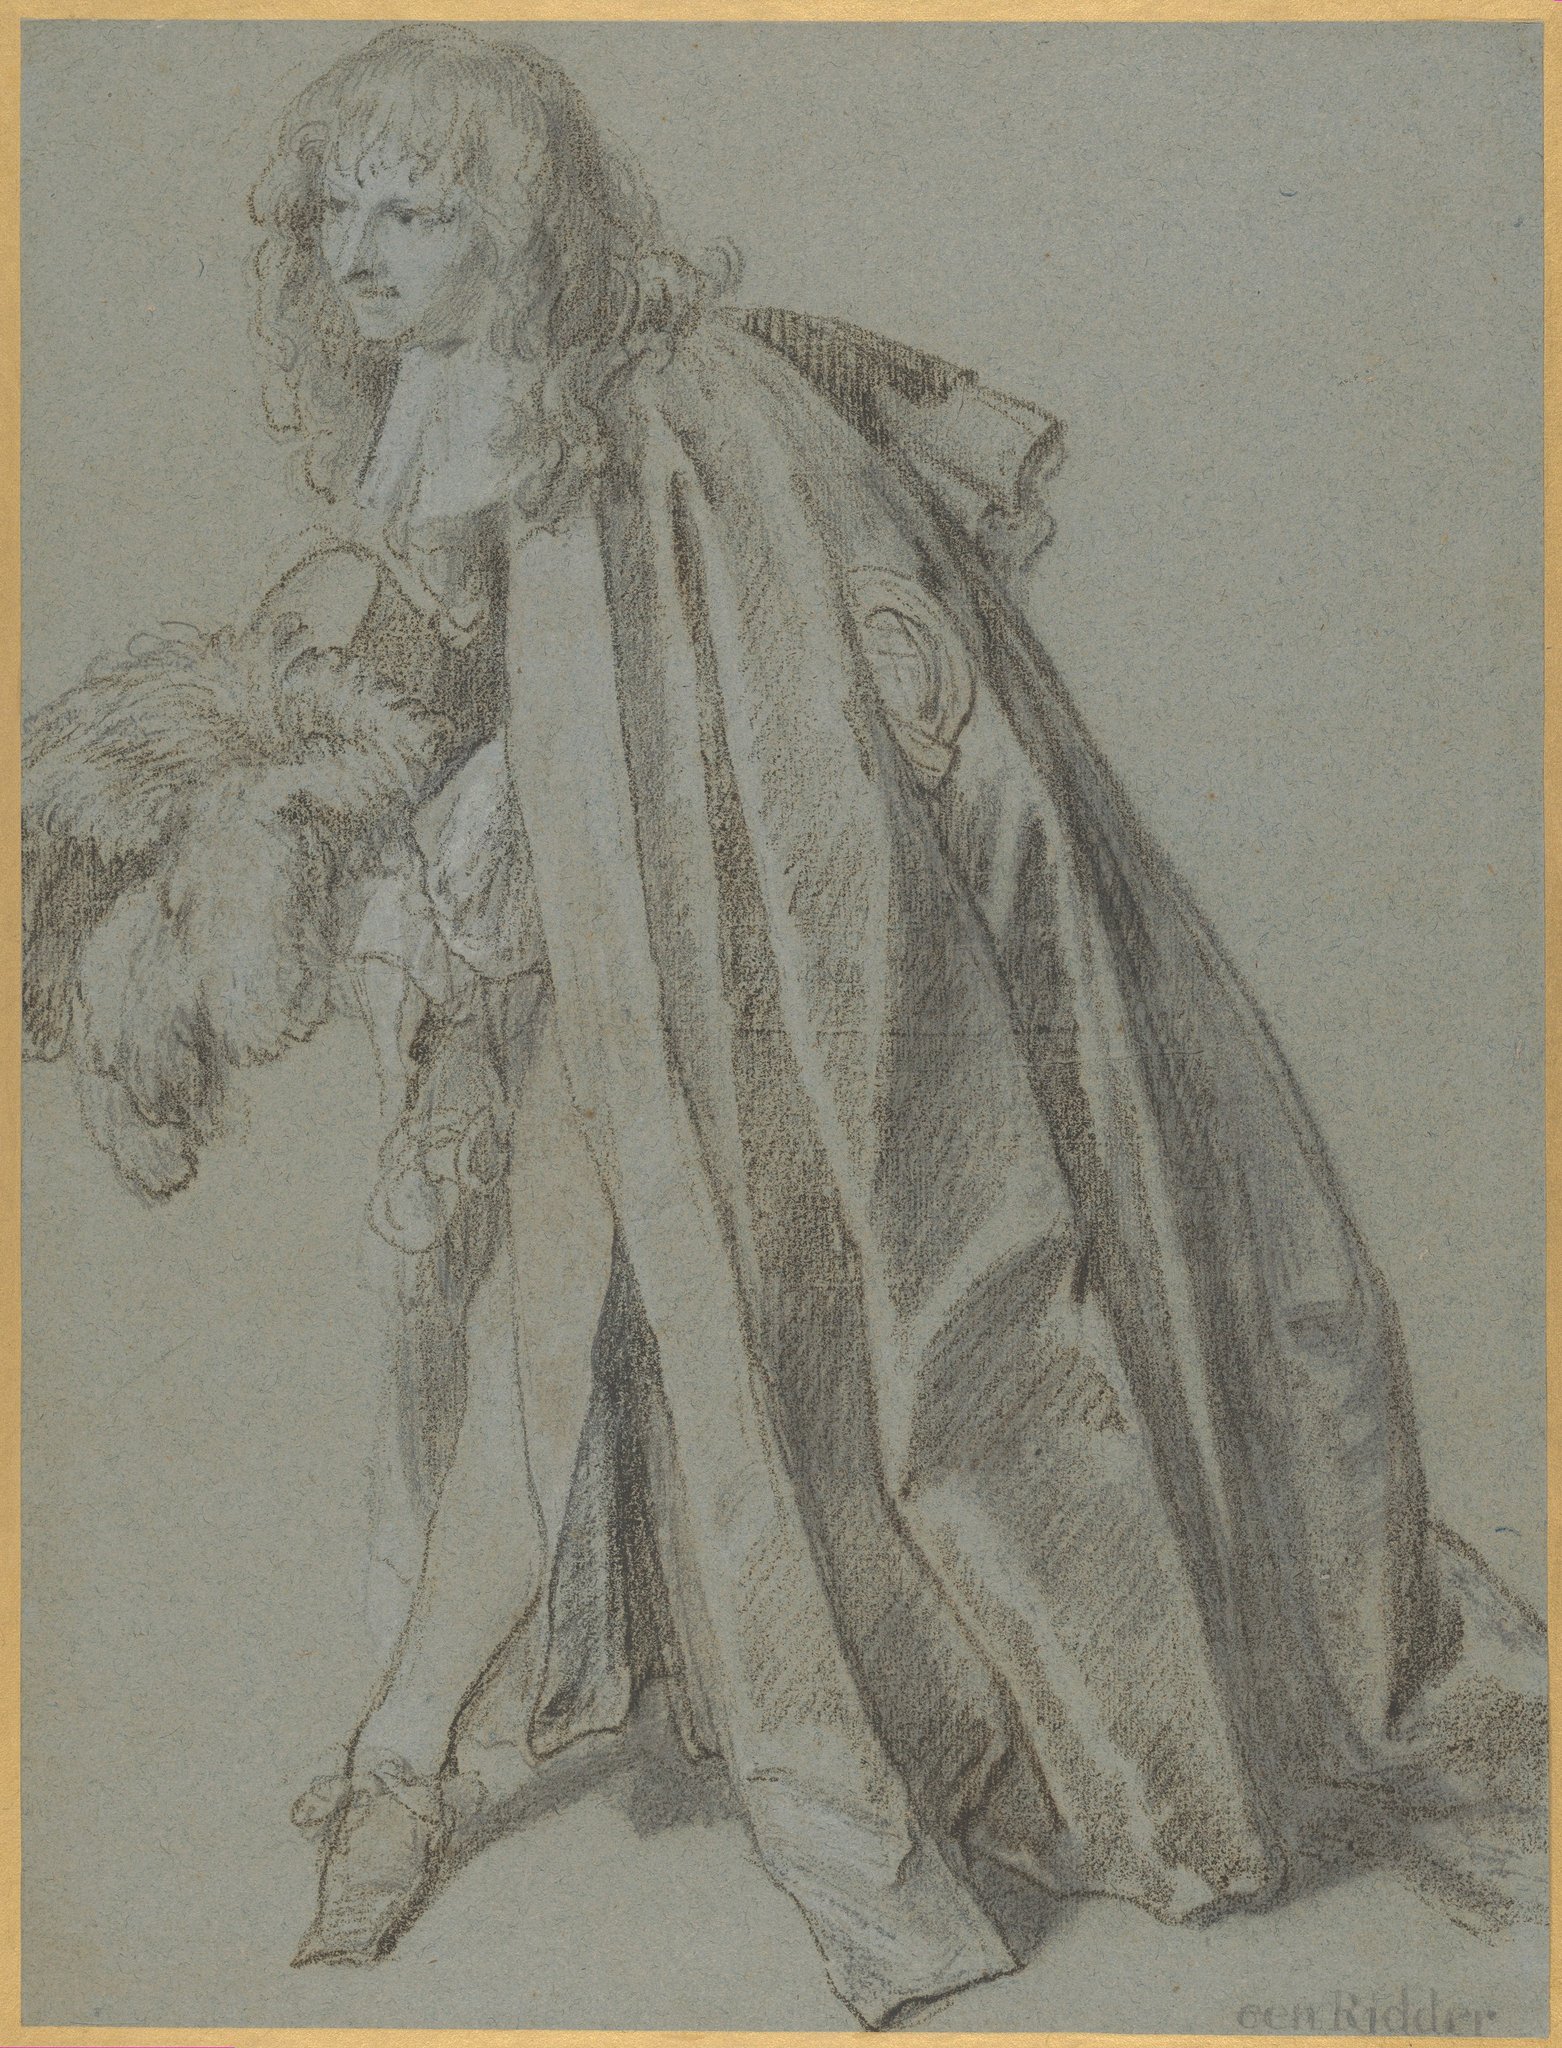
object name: drawing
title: A Knight of the Order of the Garter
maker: peter lely (sir)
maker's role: artist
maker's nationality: dutch, british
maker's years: 1618-1680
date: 1663-1671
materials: chalk, paper, pastel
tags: men,knights